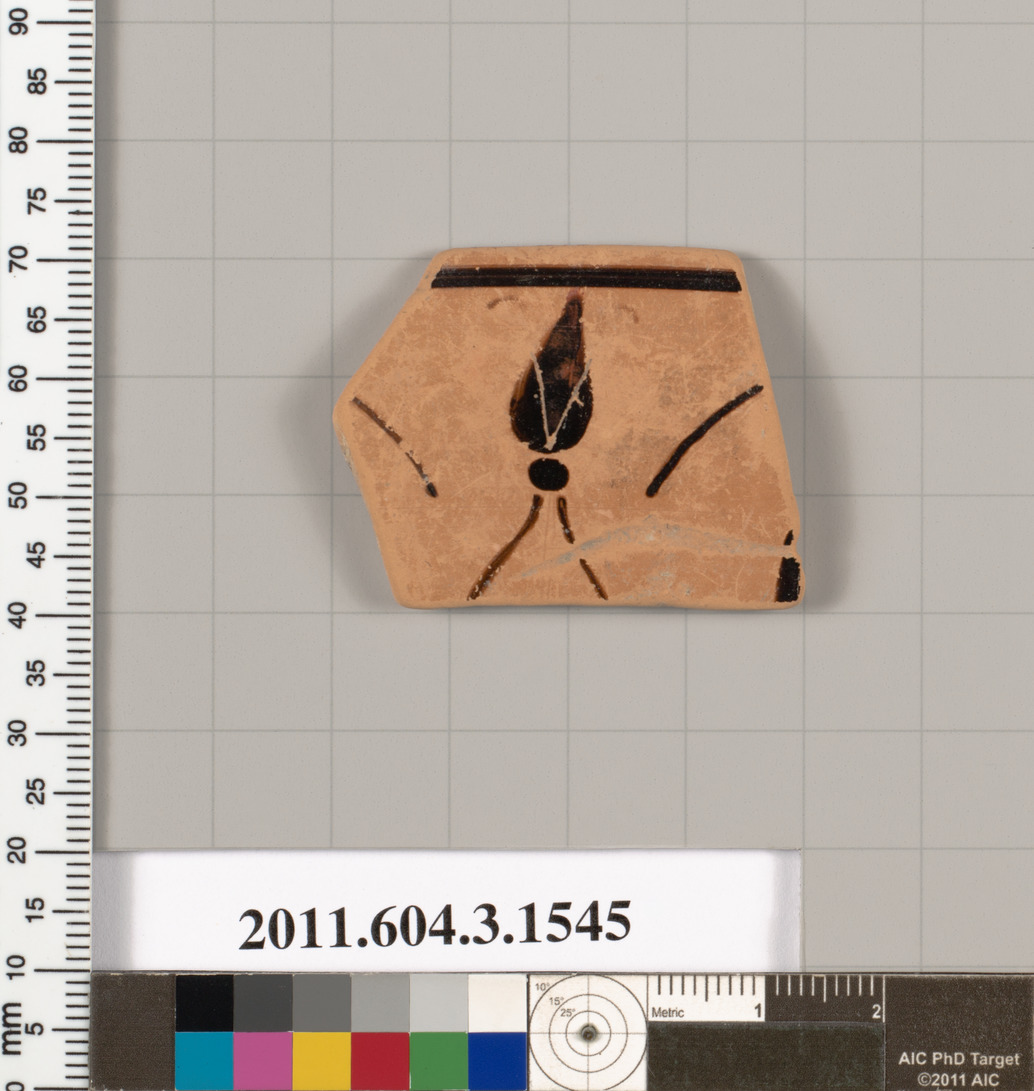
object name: kylix fragment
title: Terracotta rim fragment of a kylix: eye cup (drinking cup)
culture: greek, attic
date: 520-500 BCE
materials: terracotta